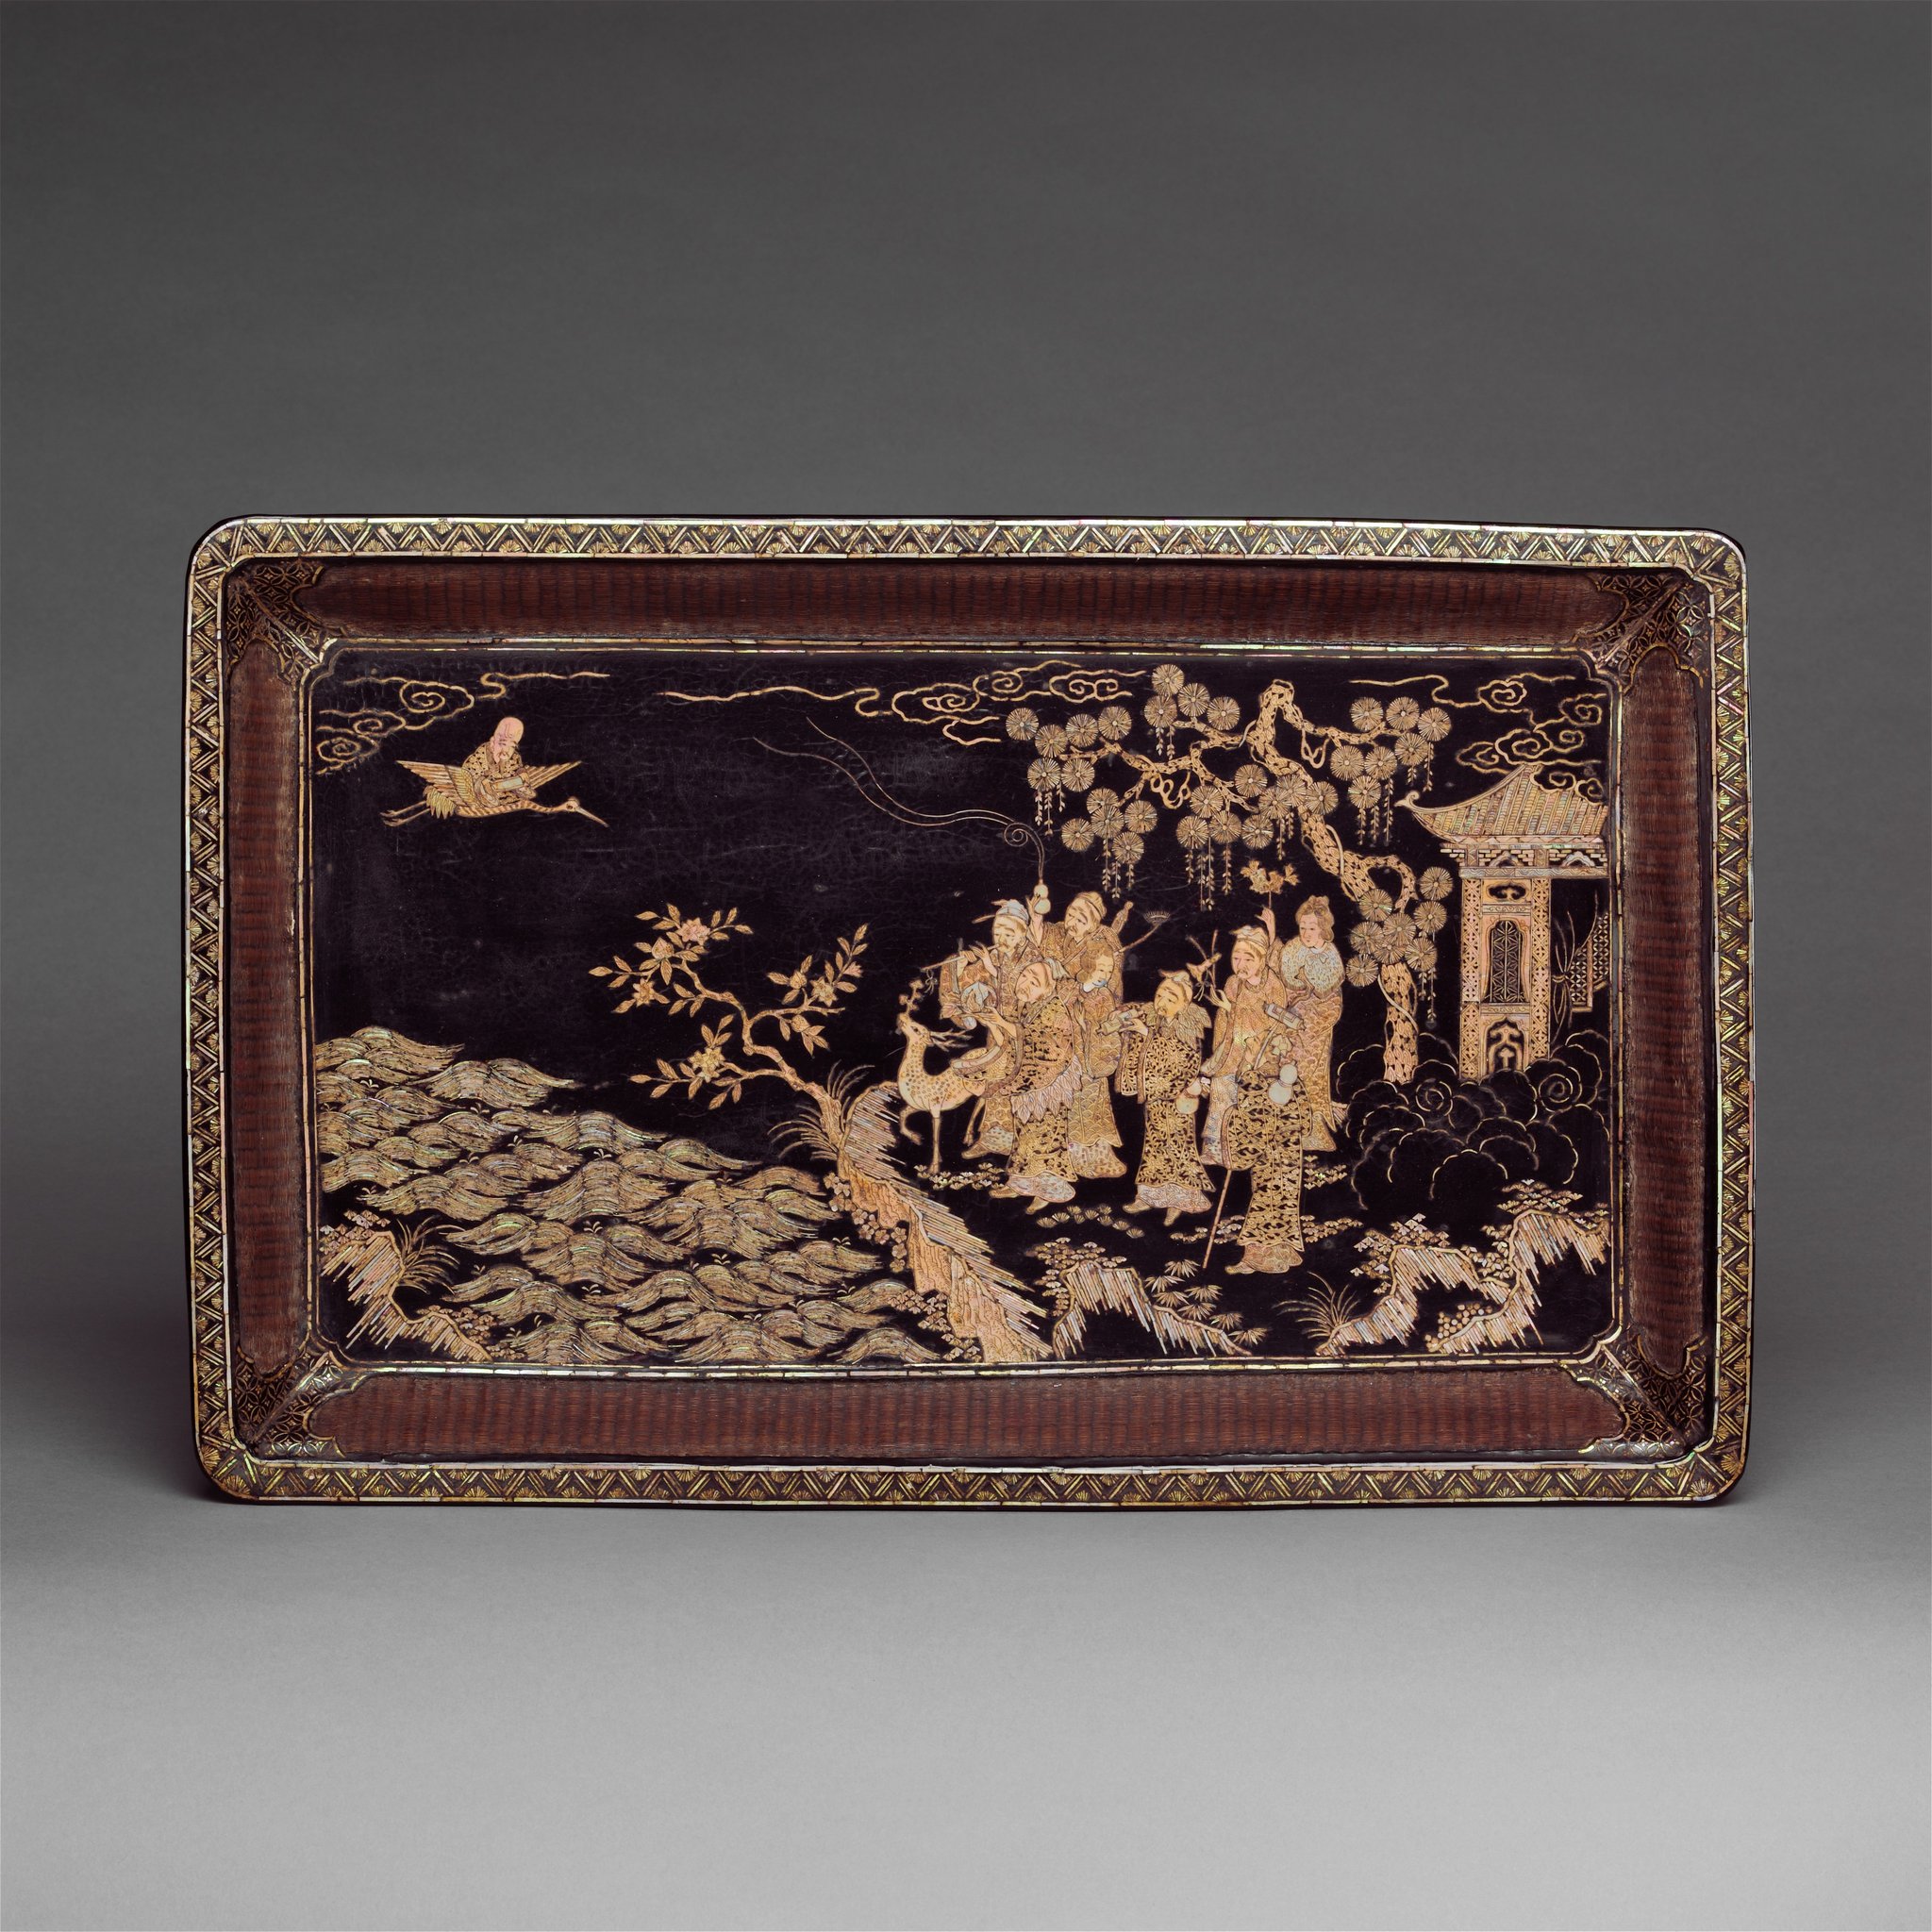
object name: tray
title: Tray with Daoist figures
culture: chinese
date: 1501-1600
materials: lacquer, mother of pearl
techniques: inlay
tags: human figures,cranes,deer,daoism